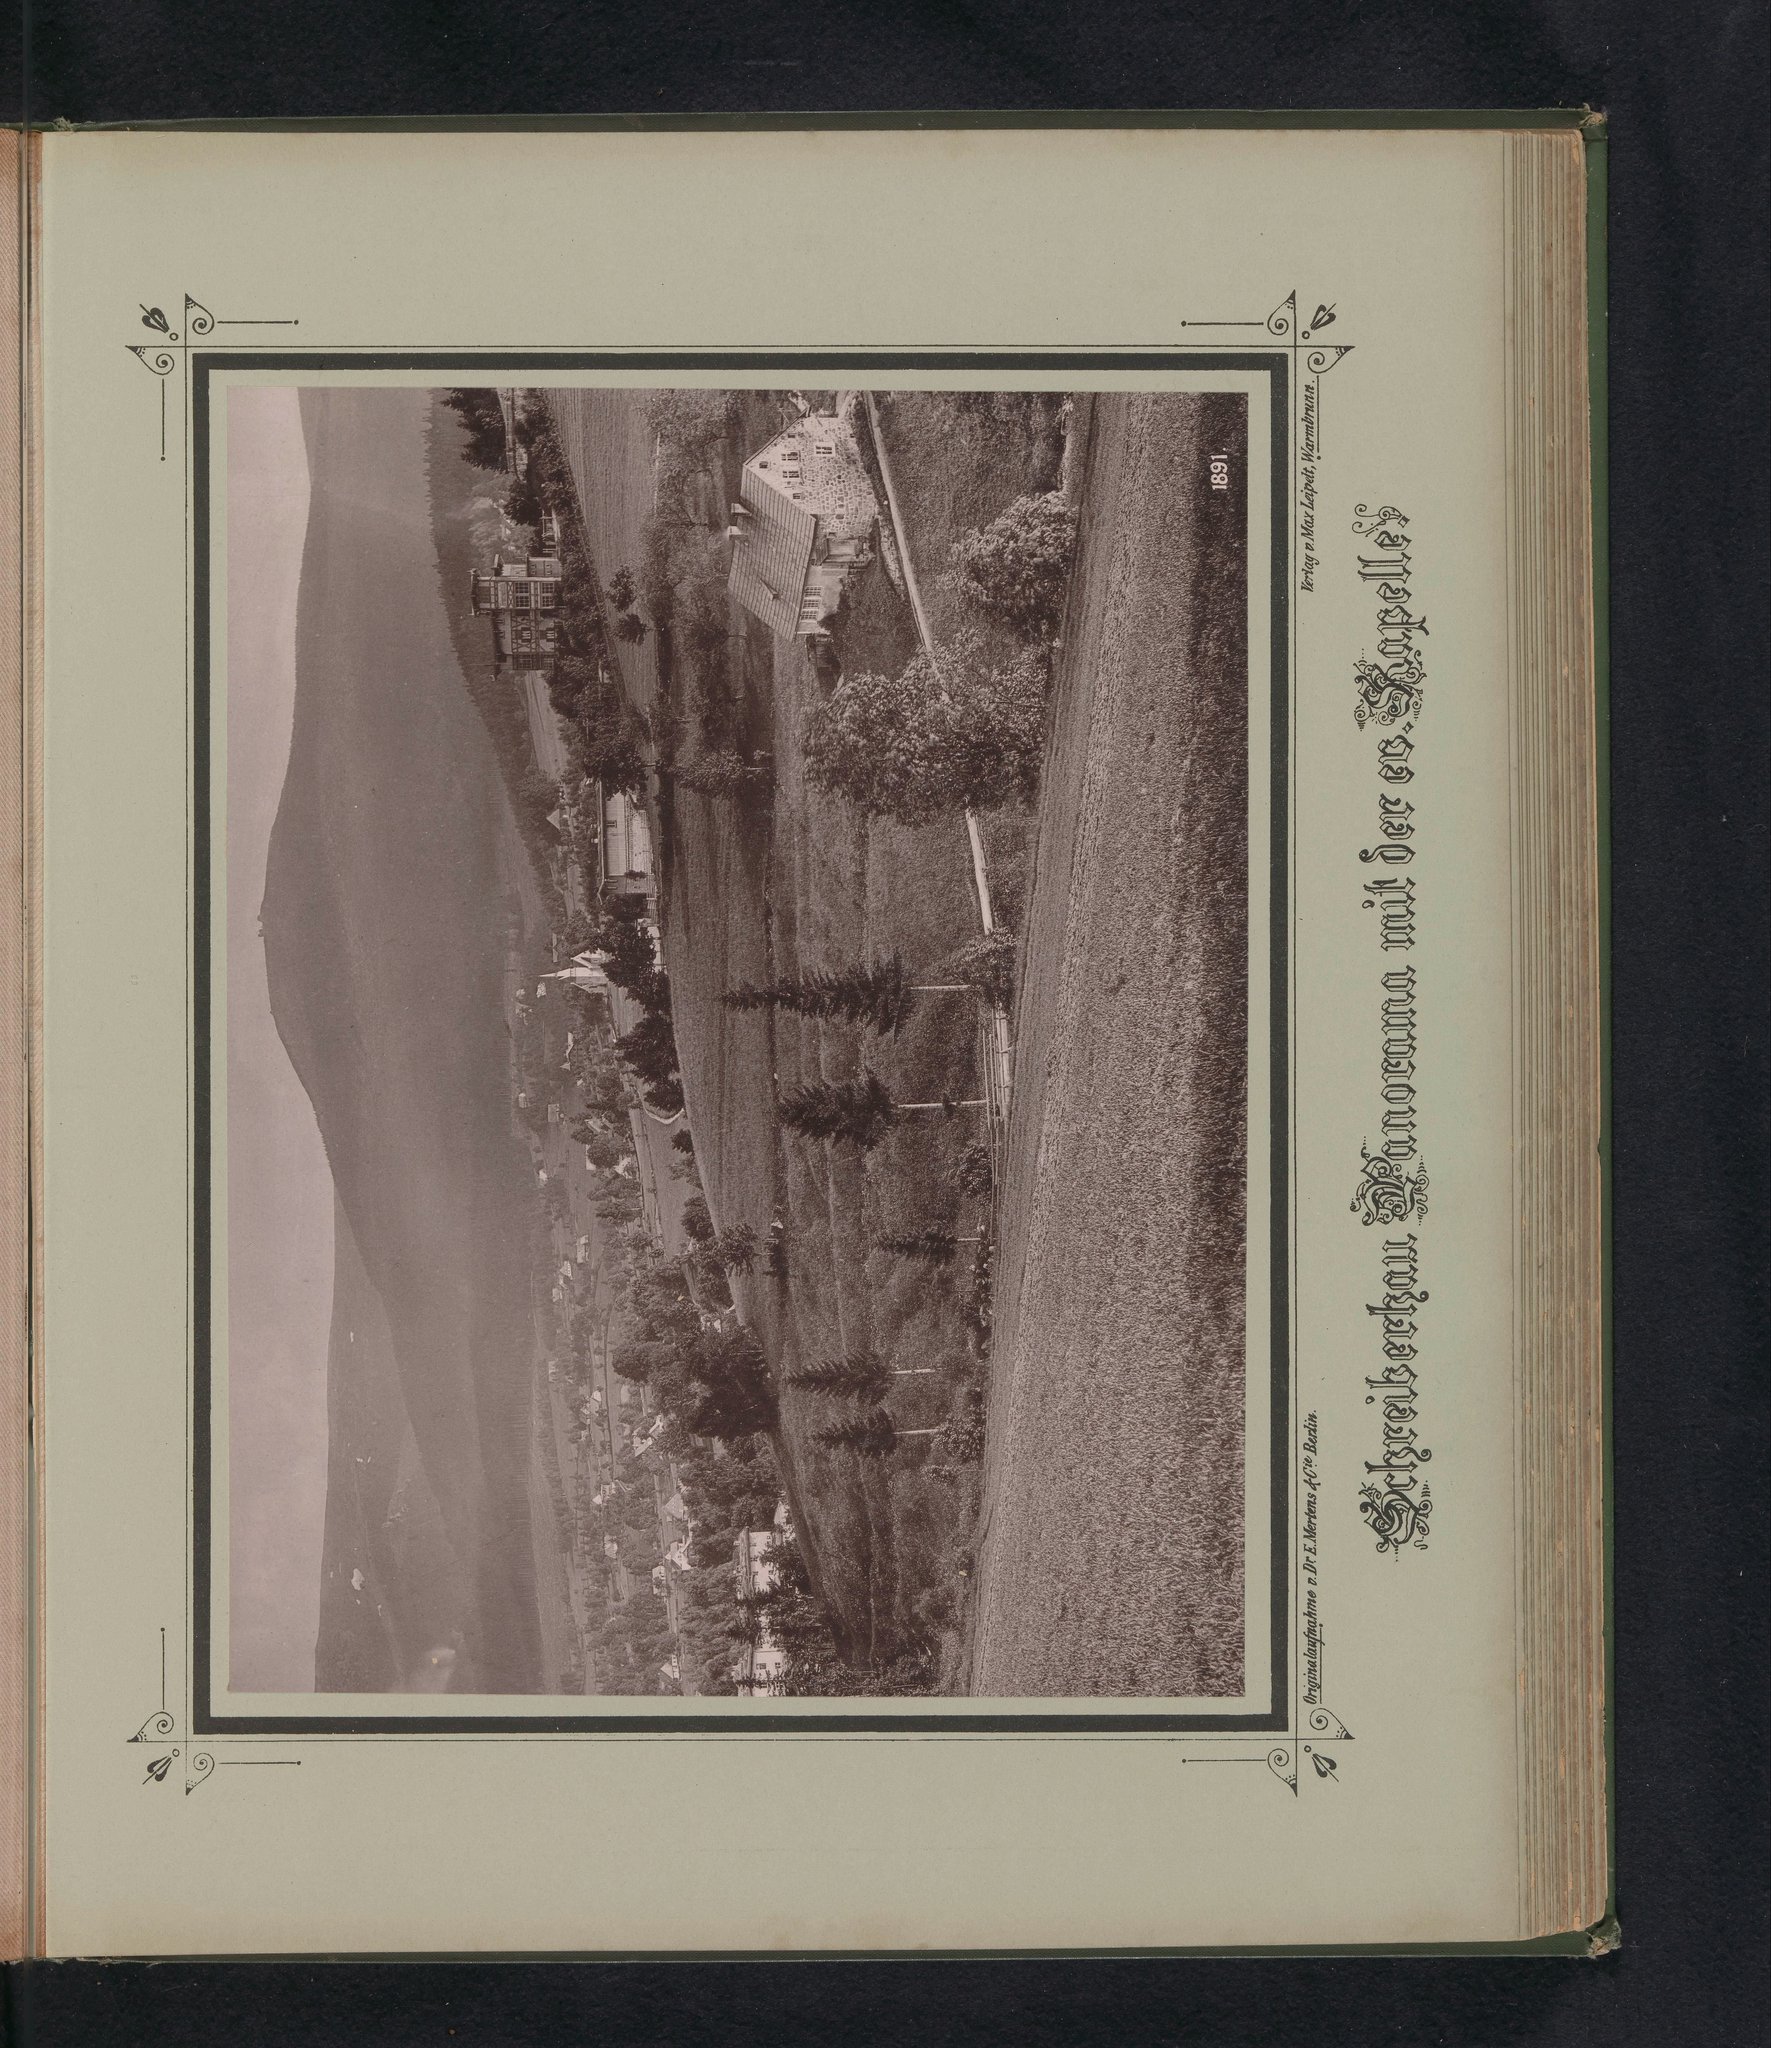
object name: page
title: Schreiberhau Panorama mit der w. Kapelle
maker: max leipelt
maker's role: publisher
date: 1891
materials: paper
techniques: photograph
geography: reuzengebergte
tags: housing, façade (of house or building)